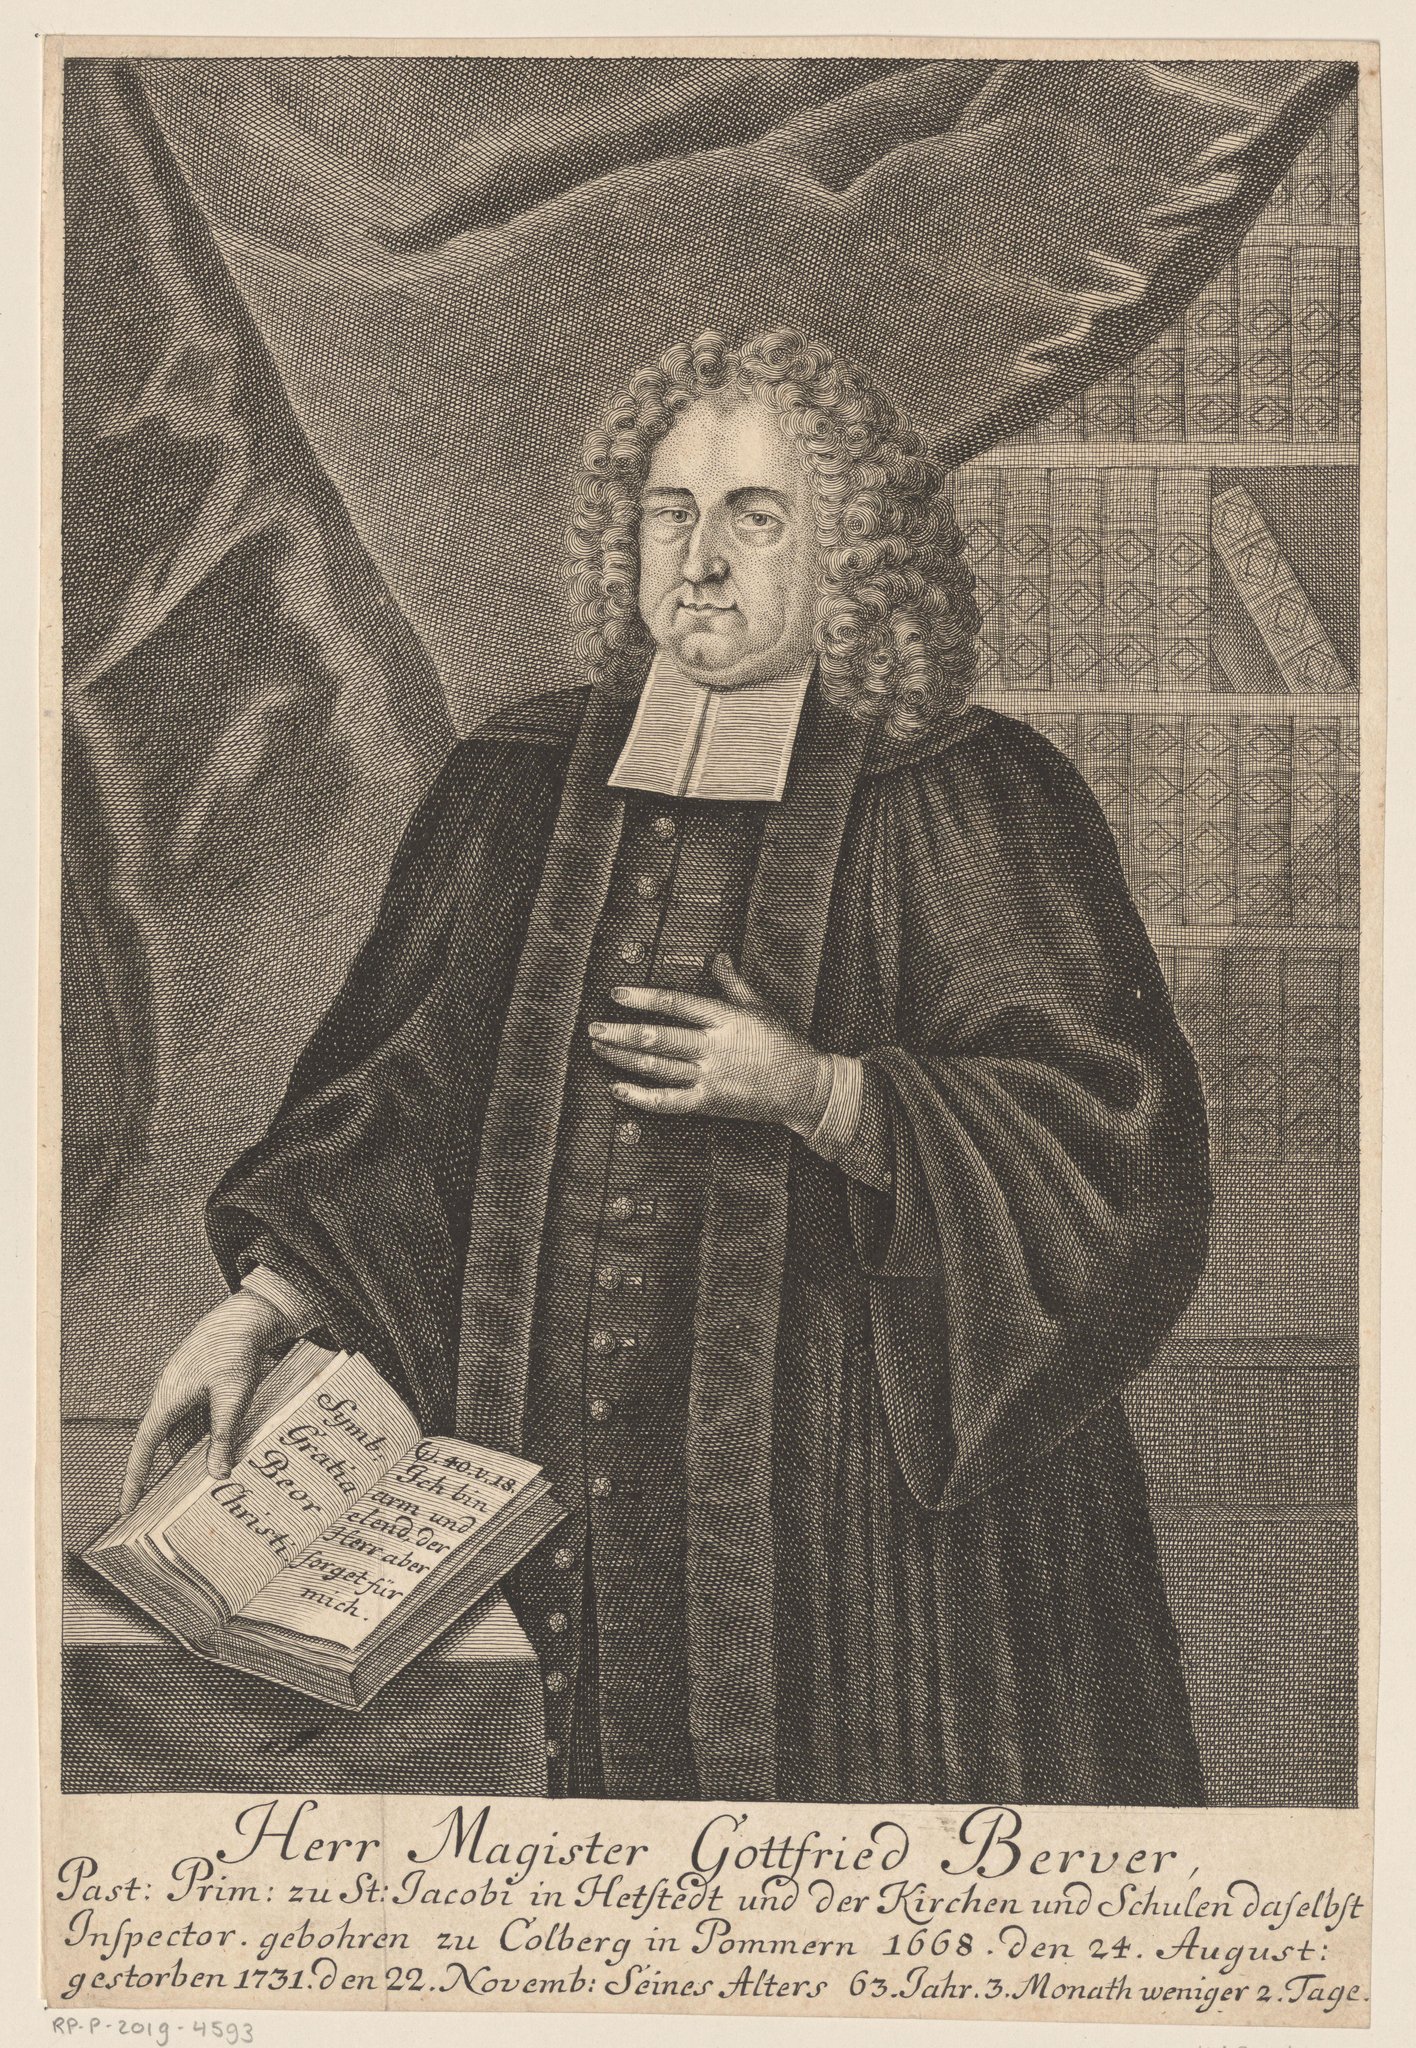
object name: print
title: Portret van Gottfried Berver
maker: Anonymous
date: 1731-1749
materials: paper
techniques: engraving, etching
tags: bookshelves, theologian, historical persons, book